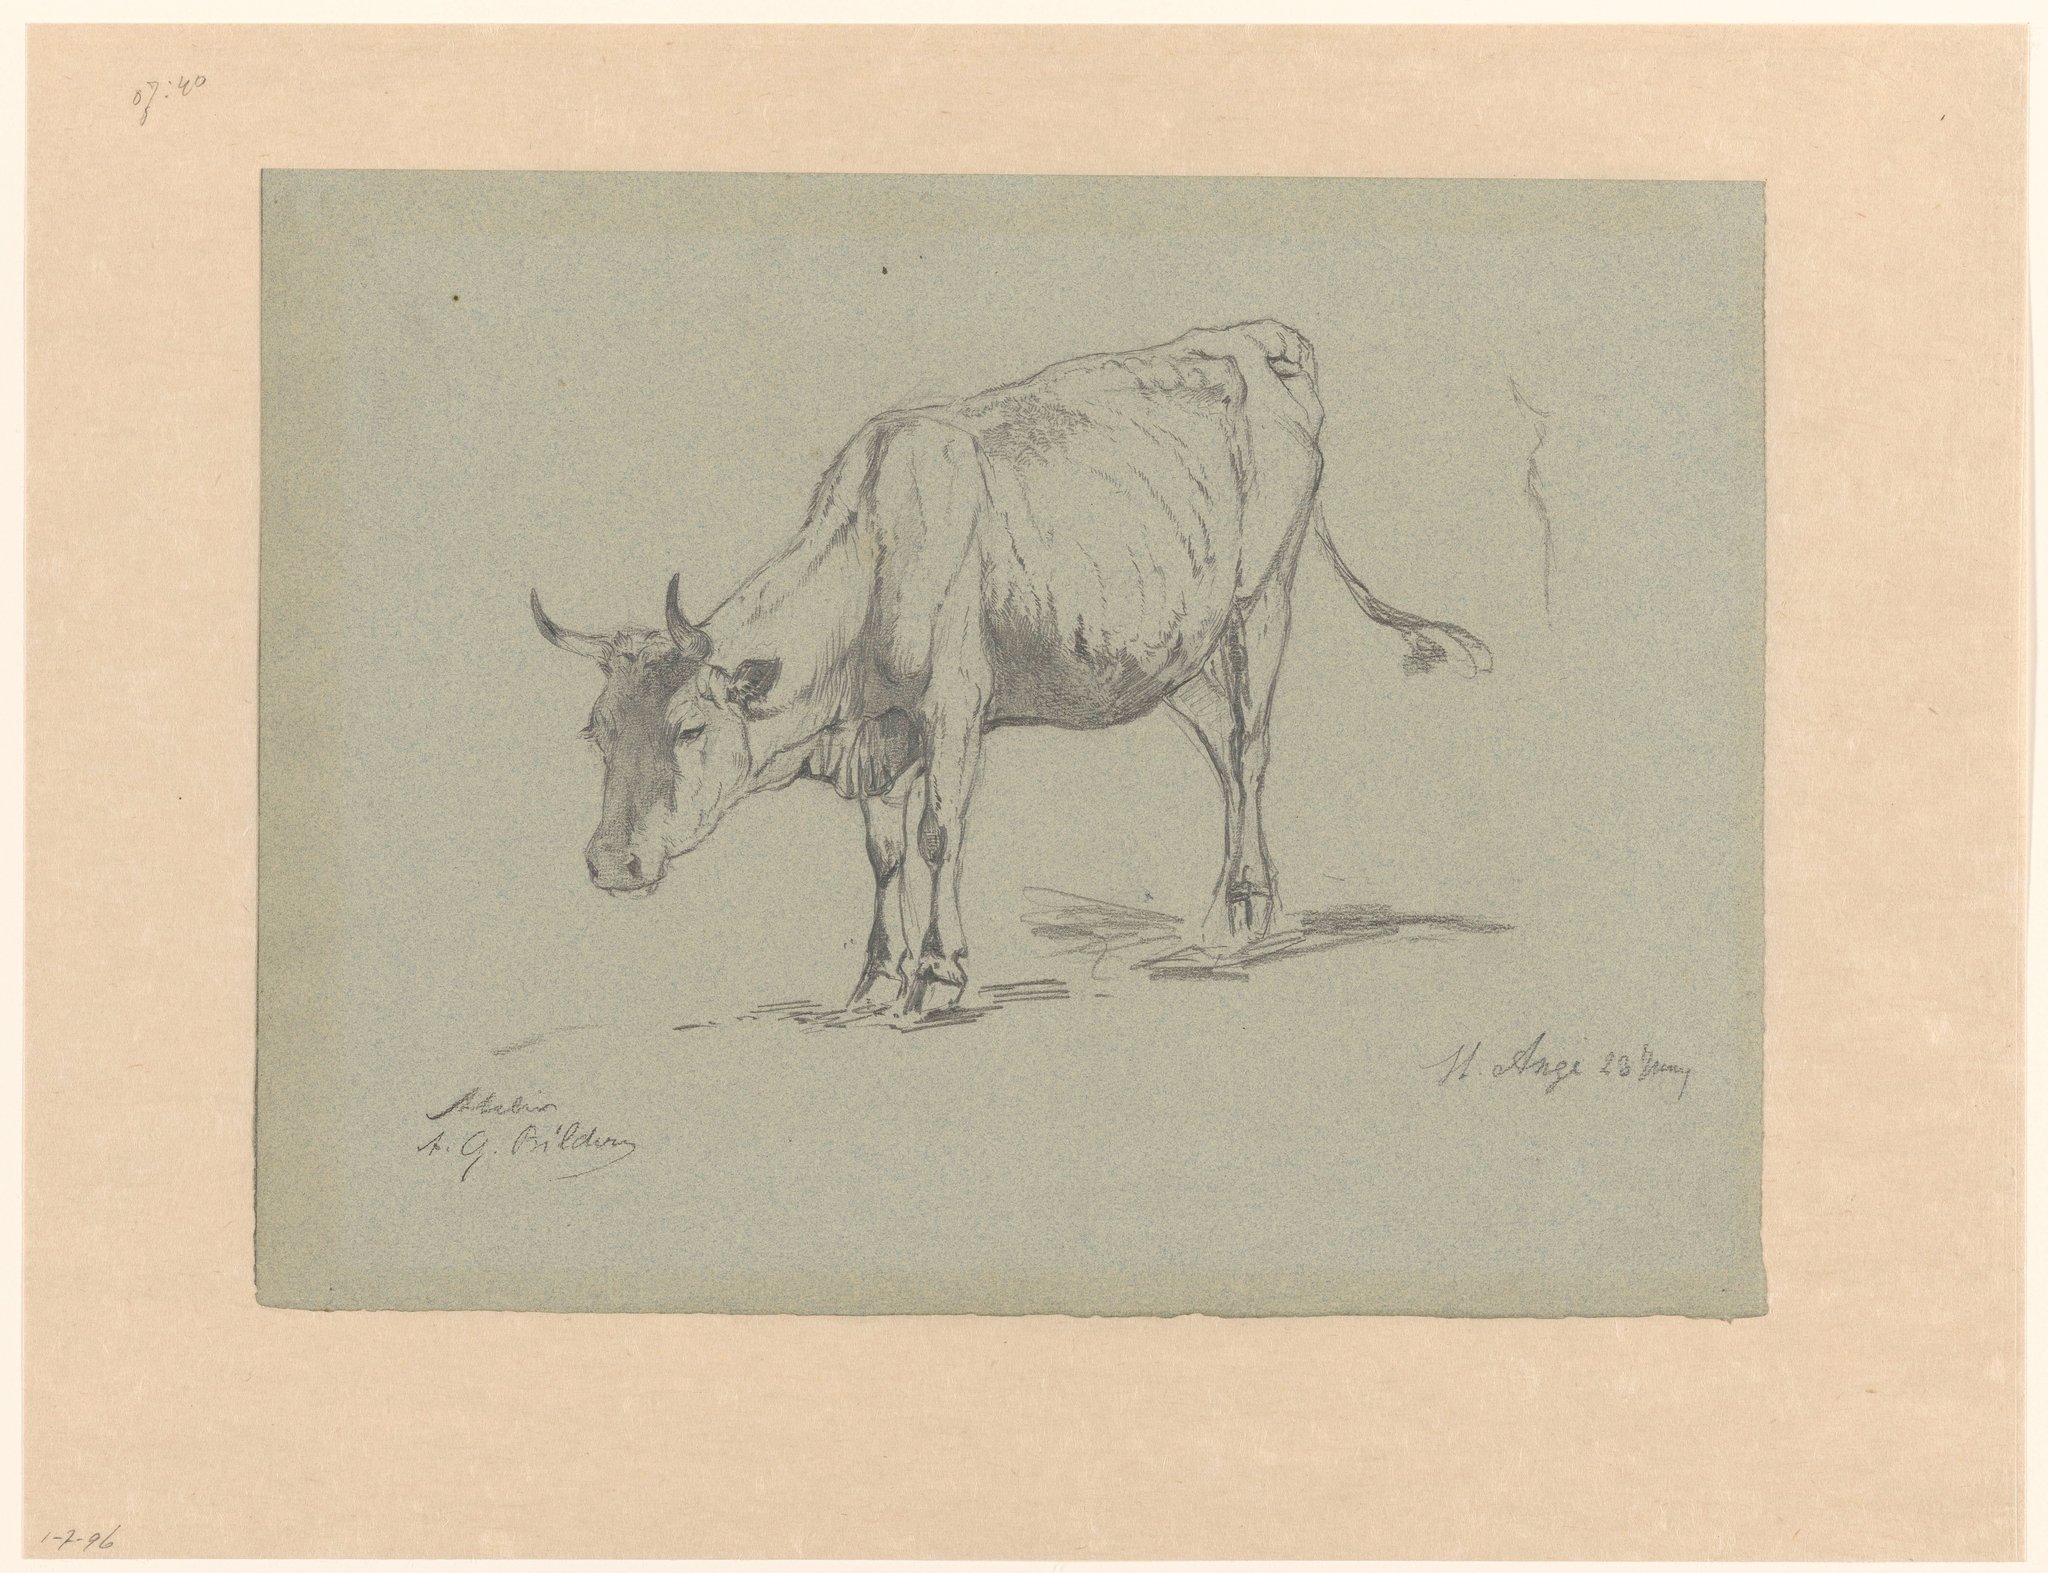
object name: drawing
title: Studie van een koe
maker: gerard bilders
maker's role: draughtsman, print maker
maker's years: 1838-1865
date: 1848-1865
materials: paper, pencil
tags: cow